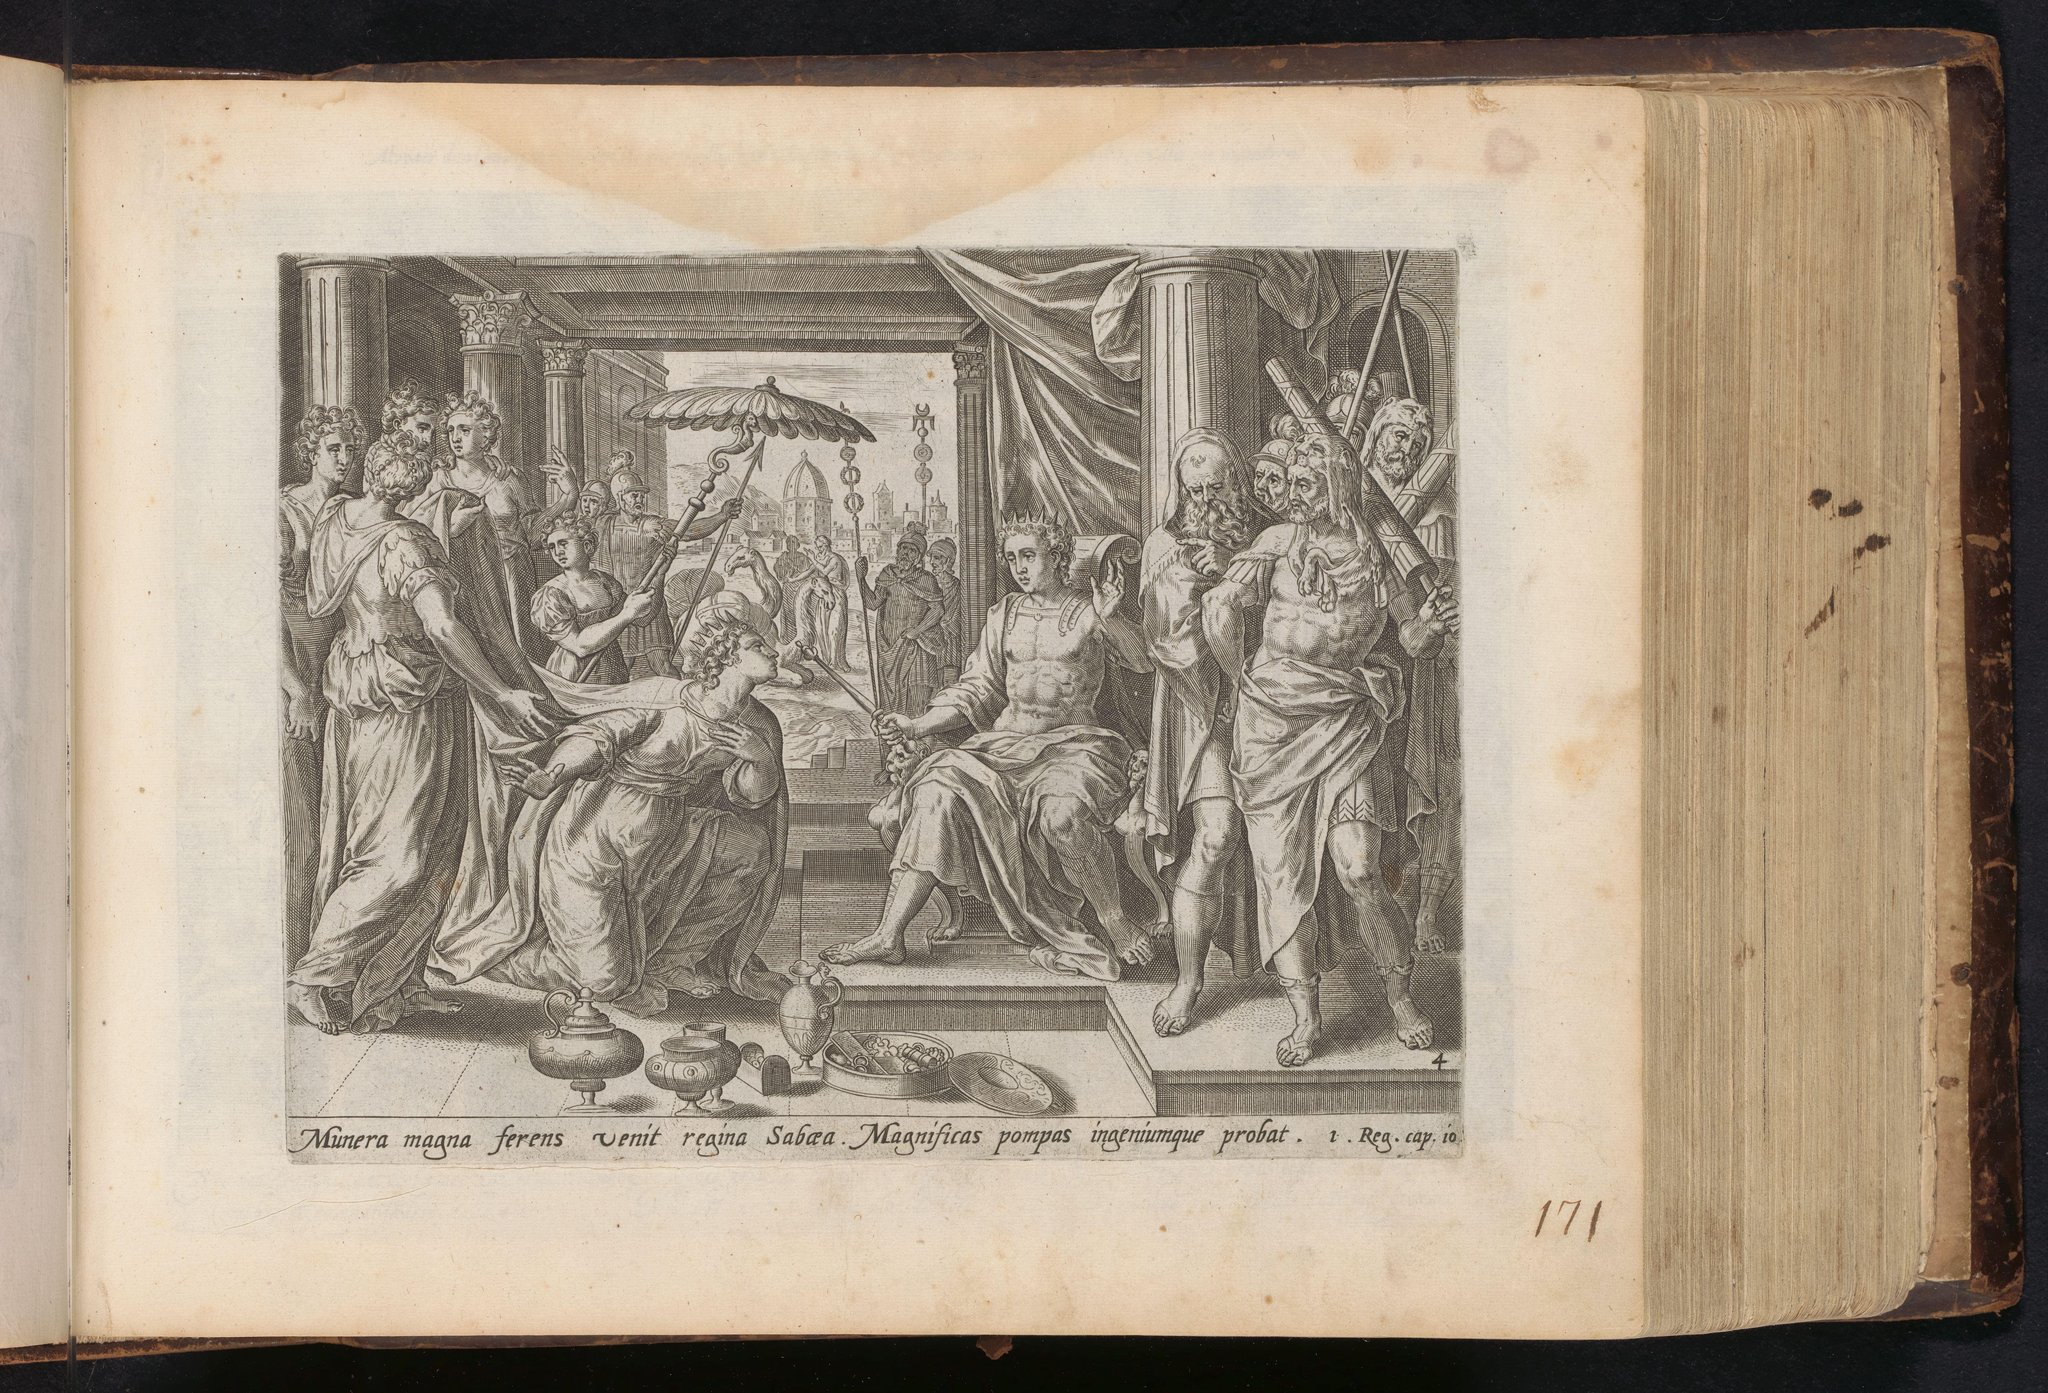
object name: album leaf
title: Den Grooten Figuer-Bibel (...)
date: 1579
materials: paper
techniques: engraving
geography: amsterdam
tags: solomon and the queen of sheba (1 kings 10:1-3; 2 chronicles 9:1-9)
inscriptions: number: ‘171’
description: De koningin van Seba knielt voor Salomo's troon. Achter haar staat haar gevolg. Op de voorgrond staan geschenken uitgestald. Onder de voorstelling een verwijzing in het Latijn naar de Bijbeltekst in 1 Kon. 10. Deze prent maakt deel uit van een album.